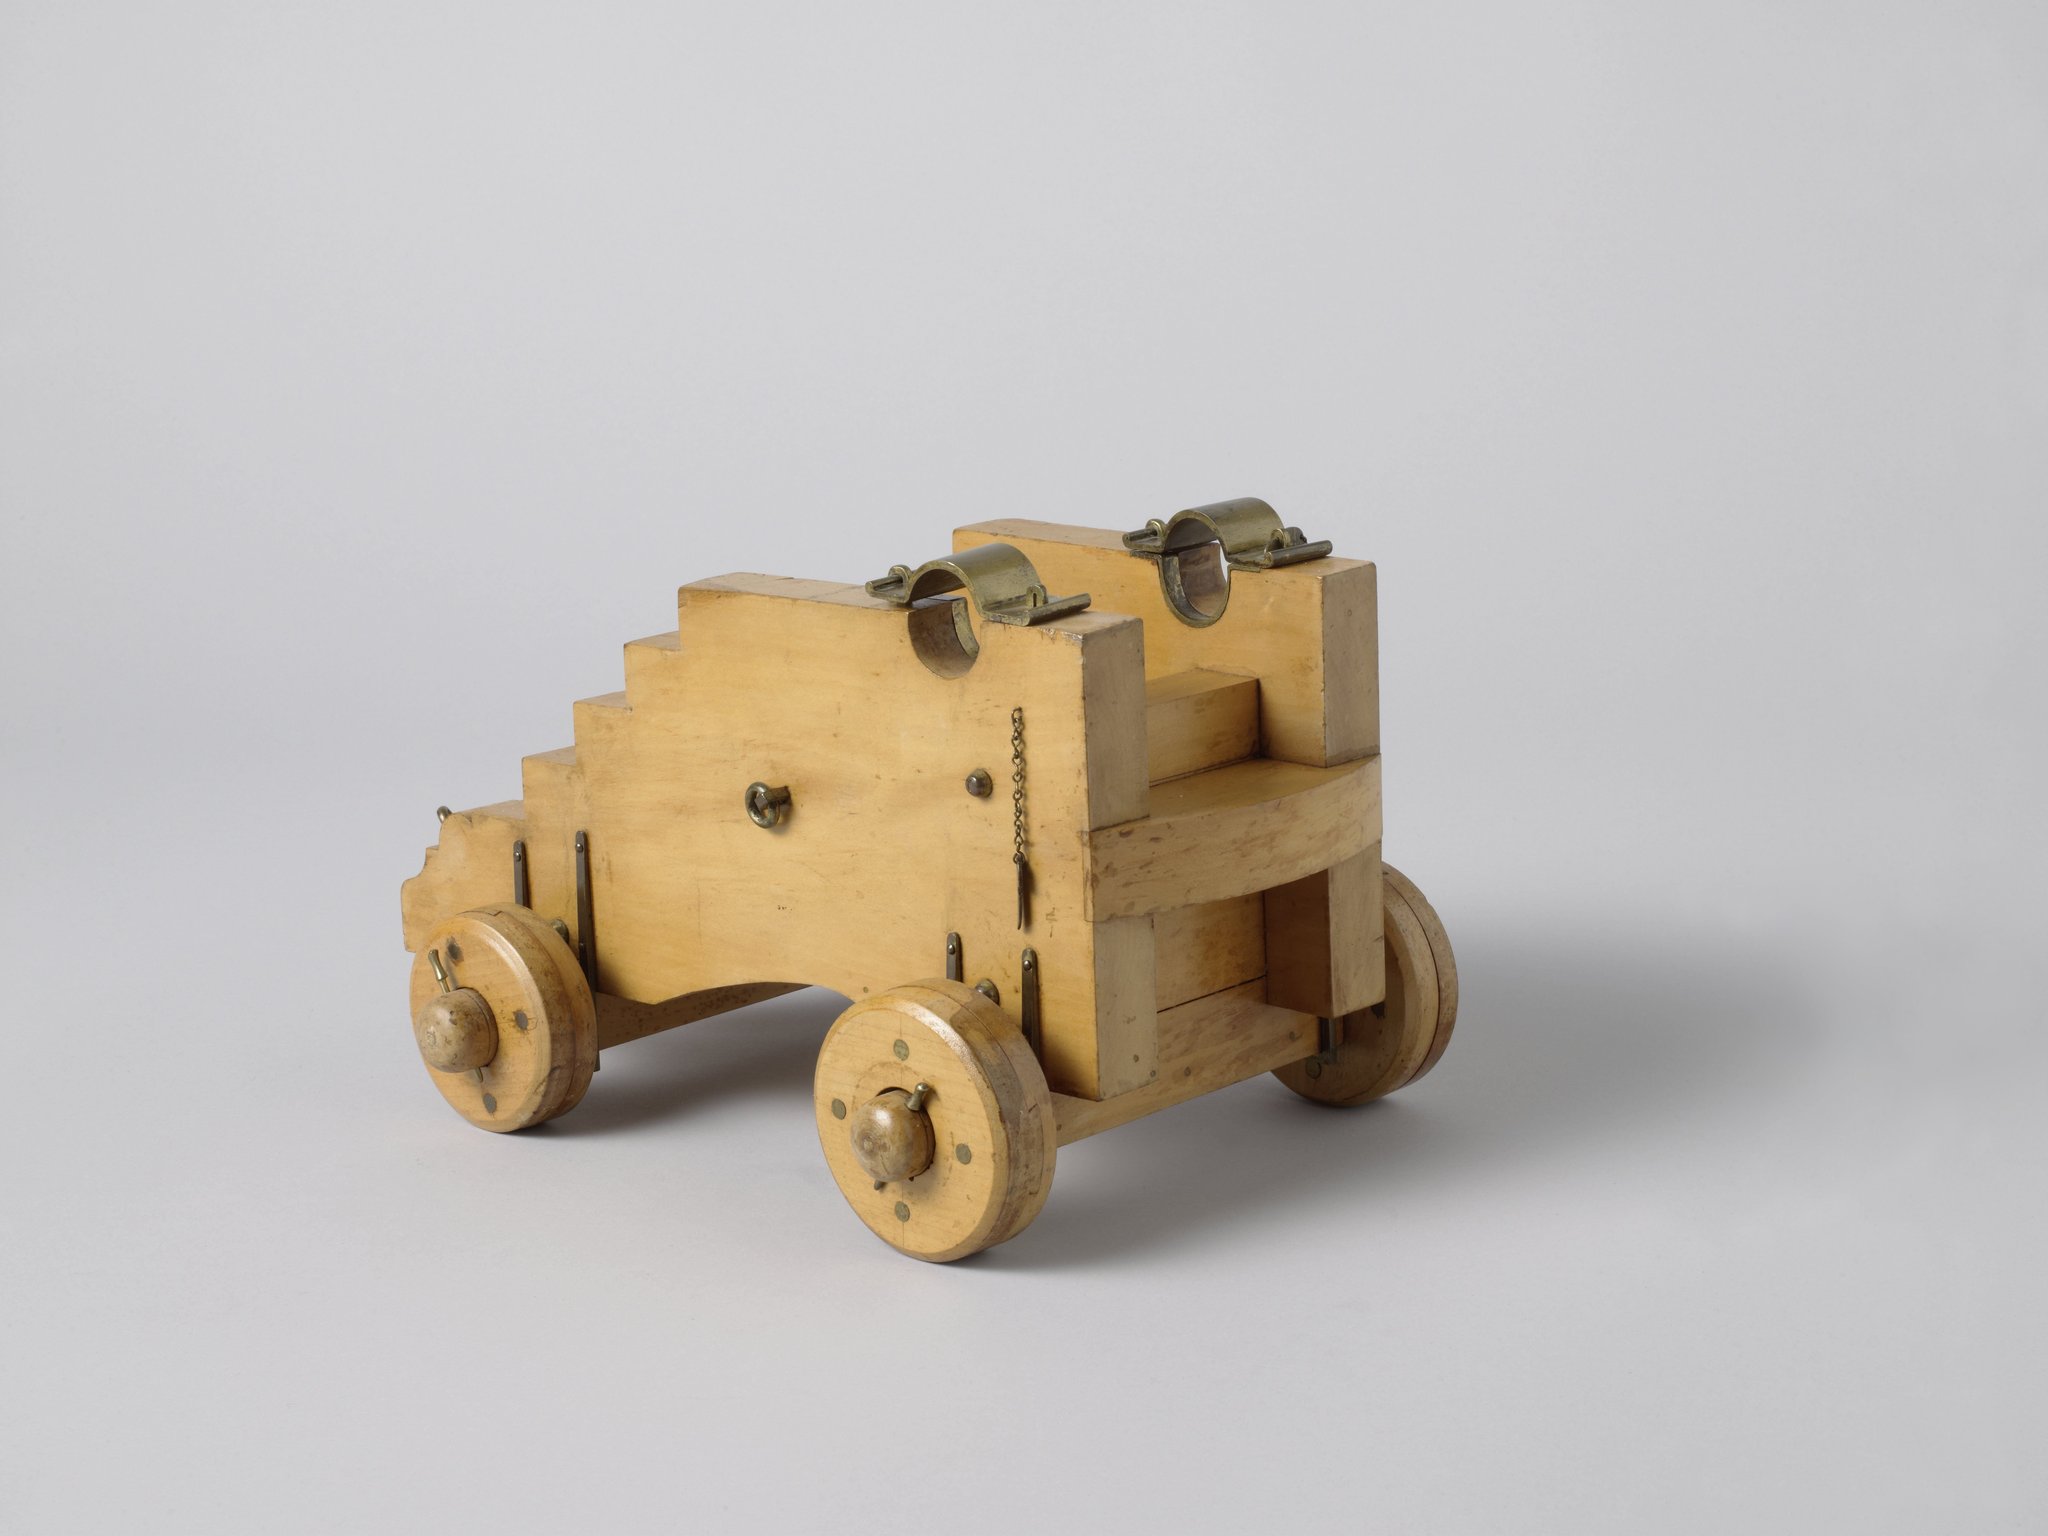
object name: demonstration model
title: Model of a Gun Carriage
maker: Anonymous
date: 1782-1820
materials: brass, wood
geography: netherlands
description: Model van een rolpaard. Het dwarsverband van de twee wangen wordt gevormd door het verticale kalf met borststuk, de zoolplaat en een dwarsbalk in het midden. De wangen hebben vier trappen en een ellipsvormige uitsnede beneden. Onder het verticale kalf en de zoolplaat zijn de aslijven opgehangen in beugels die tegen de wangen zijn gebout. De houten wielen zijn dubbel; de voorwielen zijn iets groter dan de achterwielen ter compensatie van de helling van het dek. Het model heeft messing oogbouten en tappandeksels.